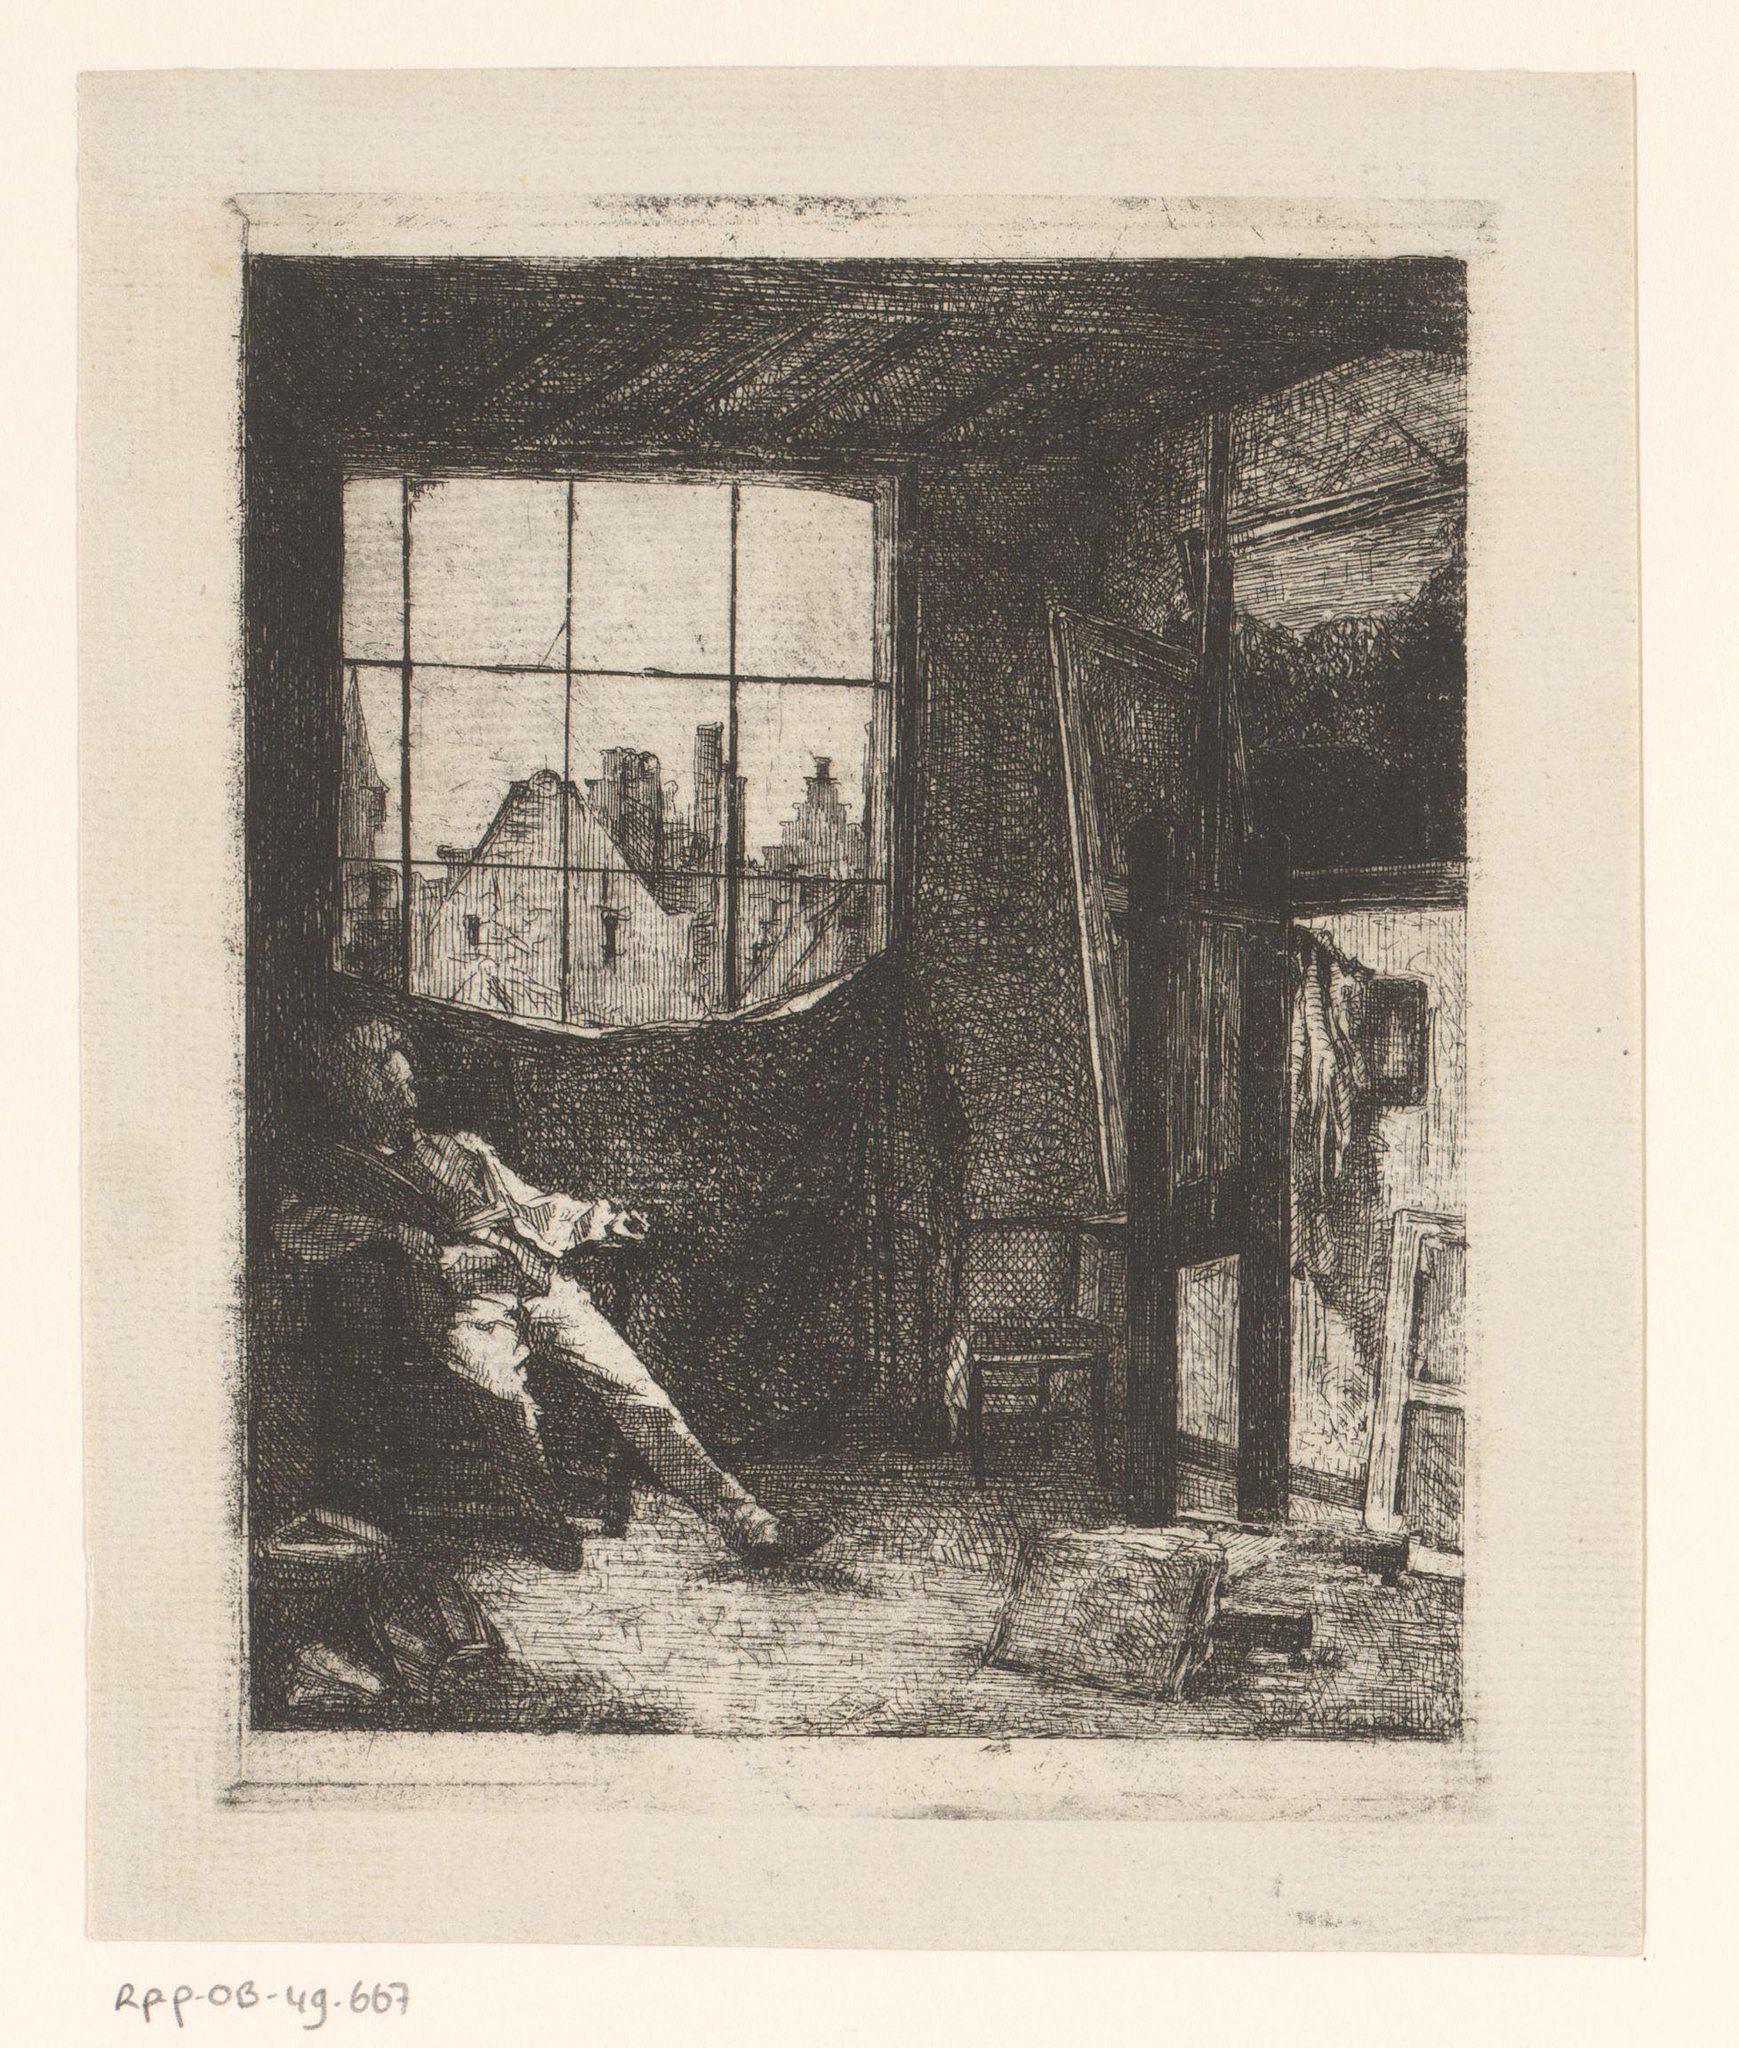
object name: print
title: Schilder aanschouwt zijn werk in zijn atelier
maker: piet verhaert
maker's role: print maker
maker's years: 1852-1908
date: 1876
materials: paper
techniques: etching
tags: window, workshop, studio ~ painter, easel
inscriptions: date